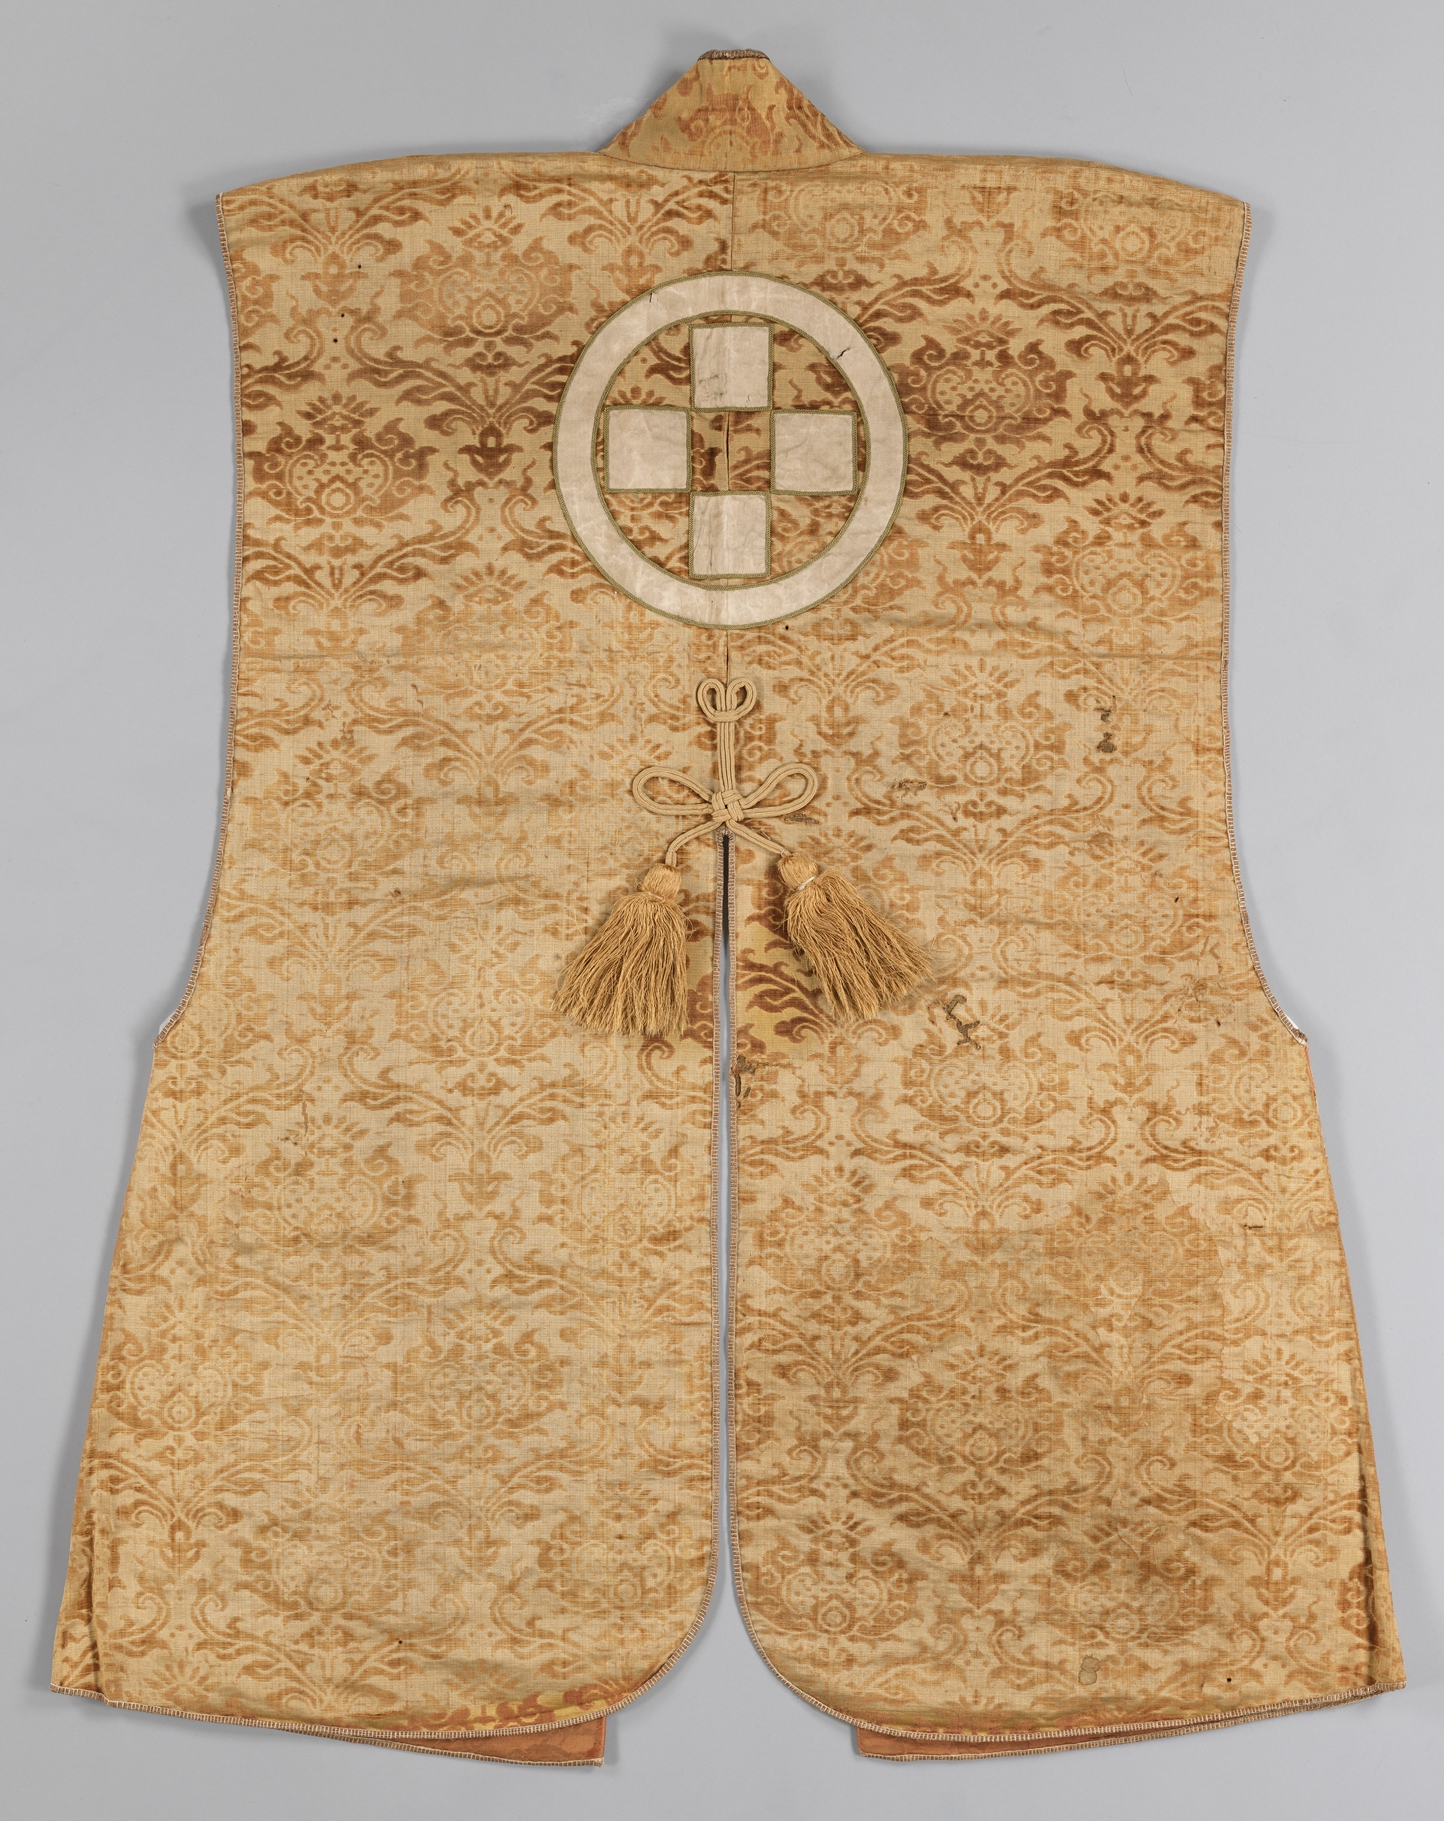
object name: surcoat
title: Surcoat (Jinbaori)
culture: japanese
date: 1601-1700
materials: gilt, paper, silk, velvet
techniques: cutting, damask, lampas, lining, voiding